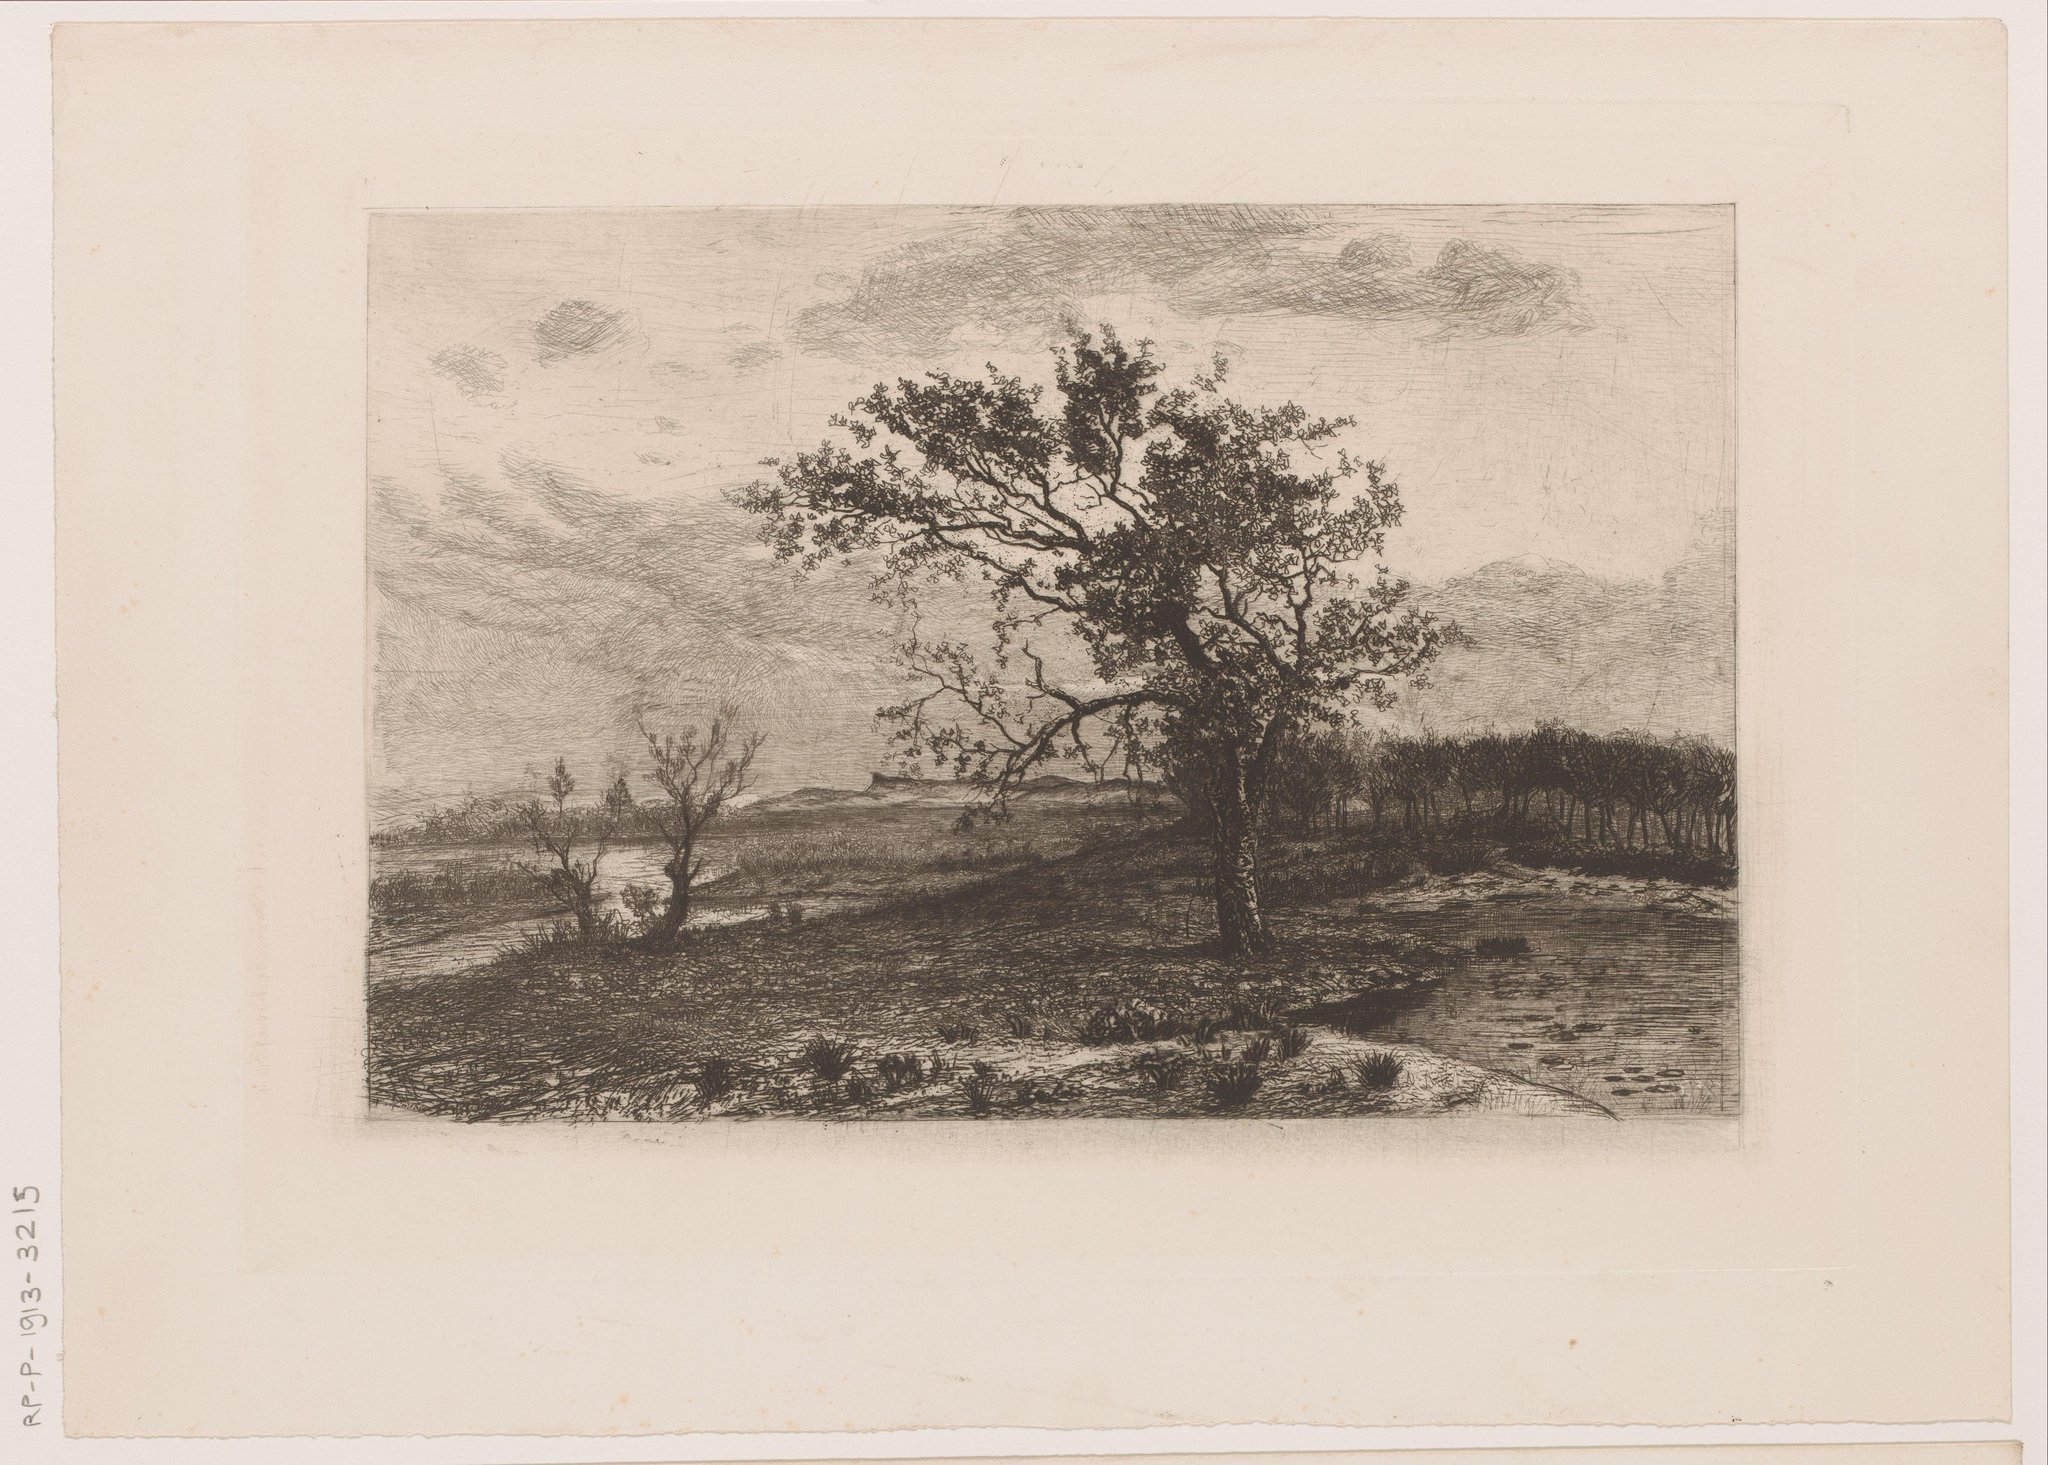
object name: print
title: Landschap in de Kempen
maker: jerôme tuyttens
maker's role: painter, print maker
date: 1850-1883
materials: paper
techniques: drypoint, etching, intaglio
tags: landscapes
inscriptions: collector's mark: Lugt 2228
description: Sterfdatum van de prentmaker is onbekend. Daarom is voor de bepaling van de rechten van dit object gebruik gemaakt van de verwervingsdatum Rijksmuseum Amsterdam.